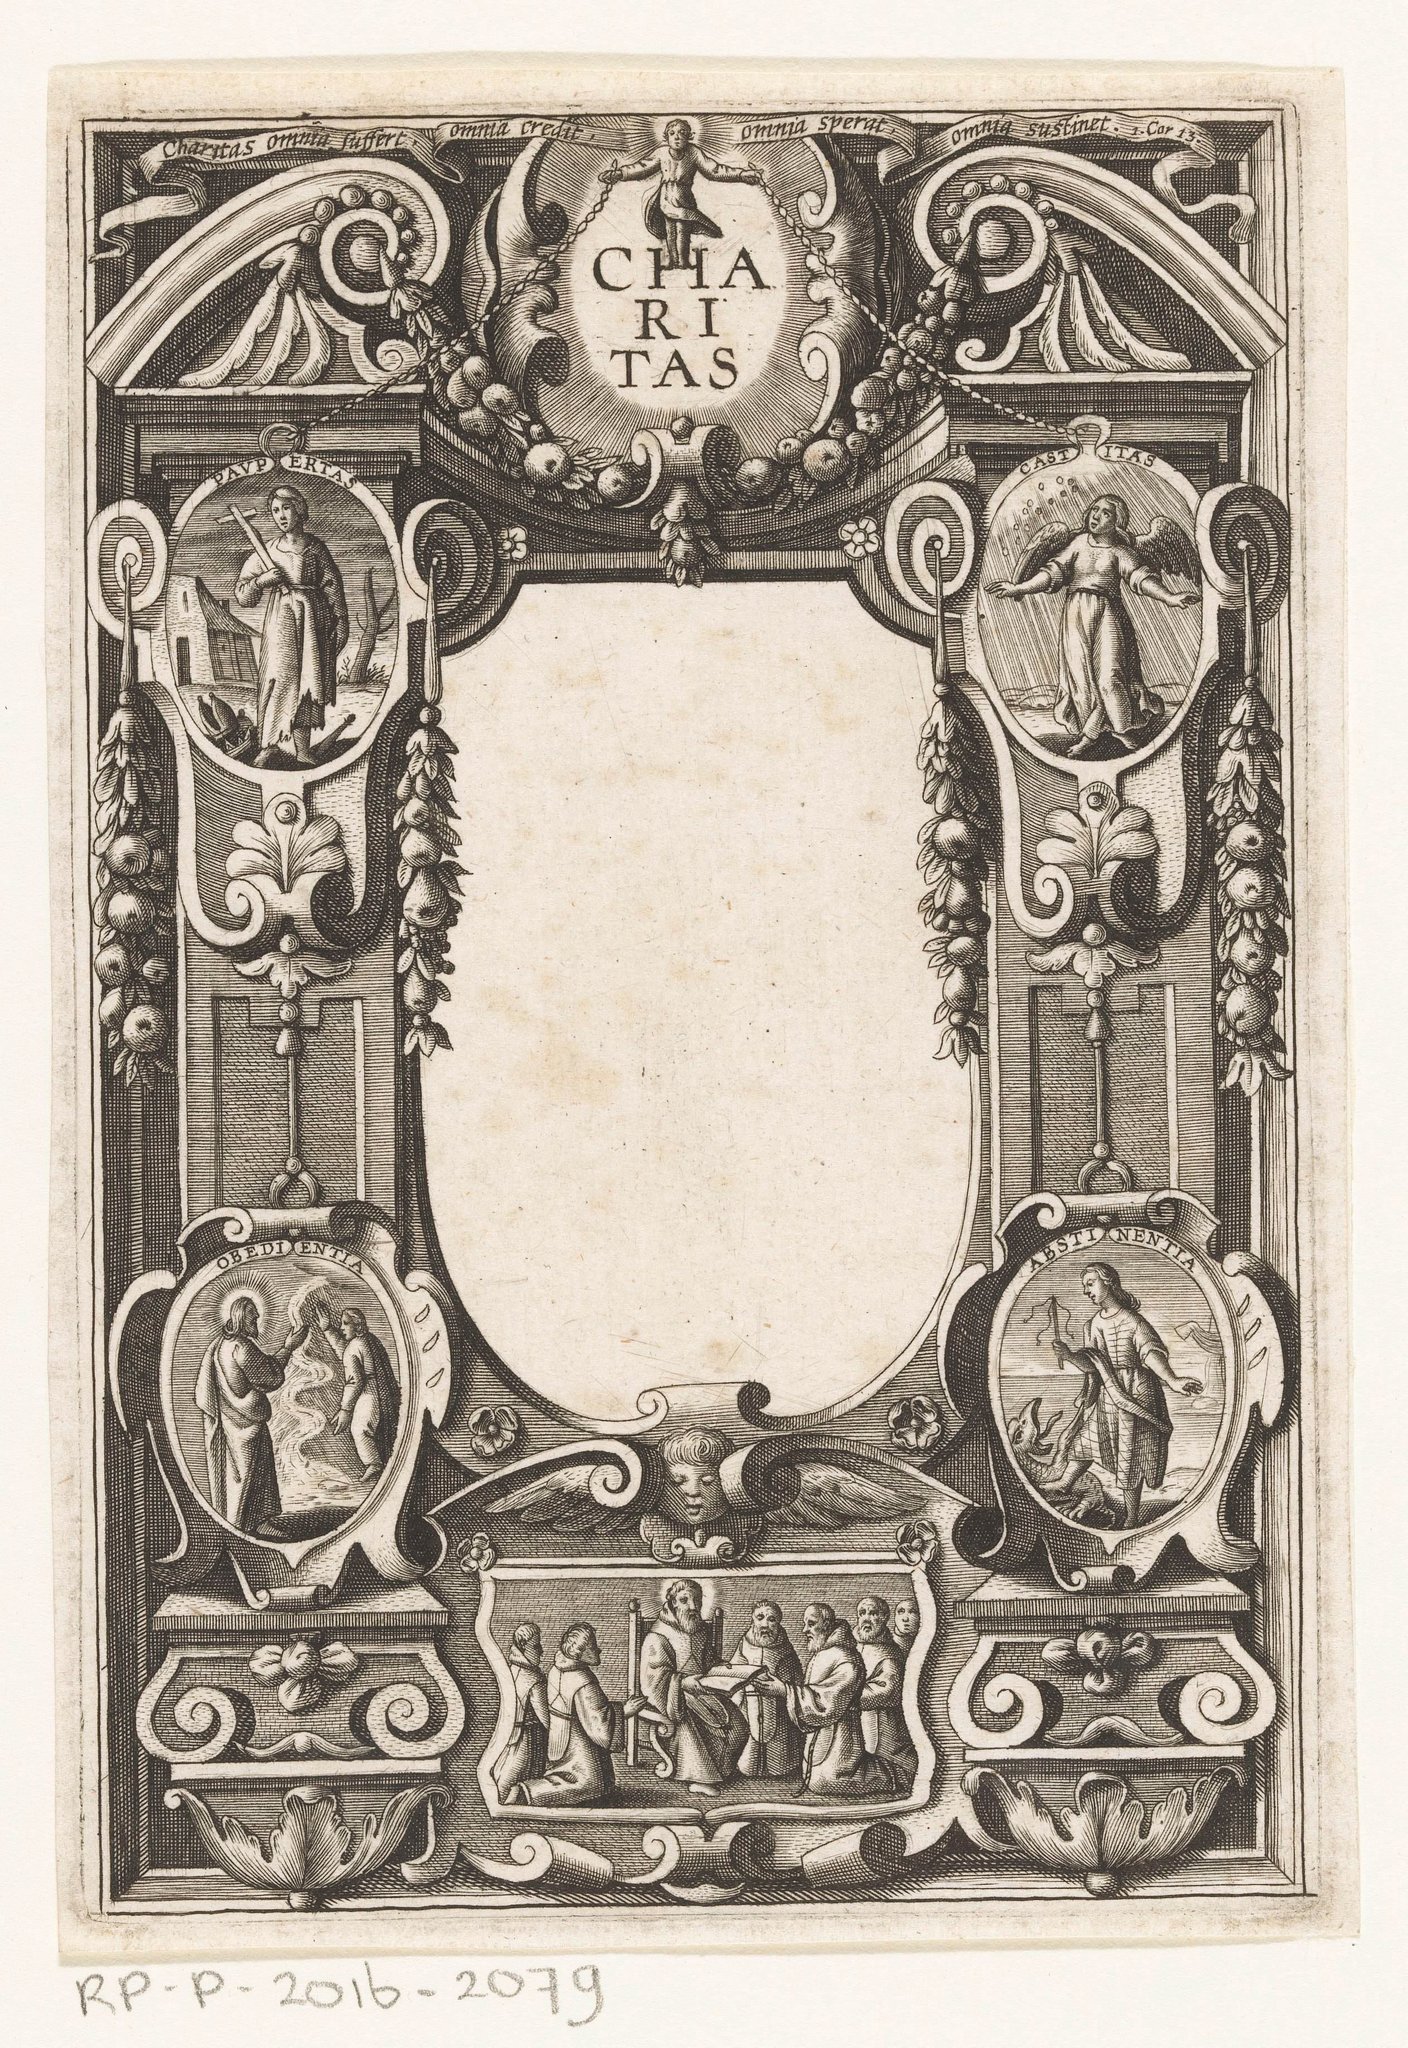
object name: print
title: Omlijsting met Armoede, Kuisheid, Gehoorzaamheid en Onthouding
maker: Anonymous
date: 1550-1650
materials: paper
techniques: engraving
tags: 'obedienza verso dio' (ripa), sobriety; 'sobrietà', 'astinenza' (ripa), 'castità ', 'pudicitia', 'vergogna honesta' (ripa), poverty; 'povertà', 'povertà del doni', 'povertà in uno ch'habbia bell'ingegno' (ripa)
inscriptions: collector's mark: Lugt 2228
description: Een ornamentele omlijsting met vier cartouches met de personificaties Armoede (Paupertas), Kuisheid (Castitas), Gehoorzaamheid (Obedientia) en Onthouding (Abstinentia). Aan de onderzijde een cartouche met zes knielende mannen rondom een man met boek en stralenkrans. Aan de bovenzijde een cartouche met titel Caritas (Liefde) en een banderol met spreuk.